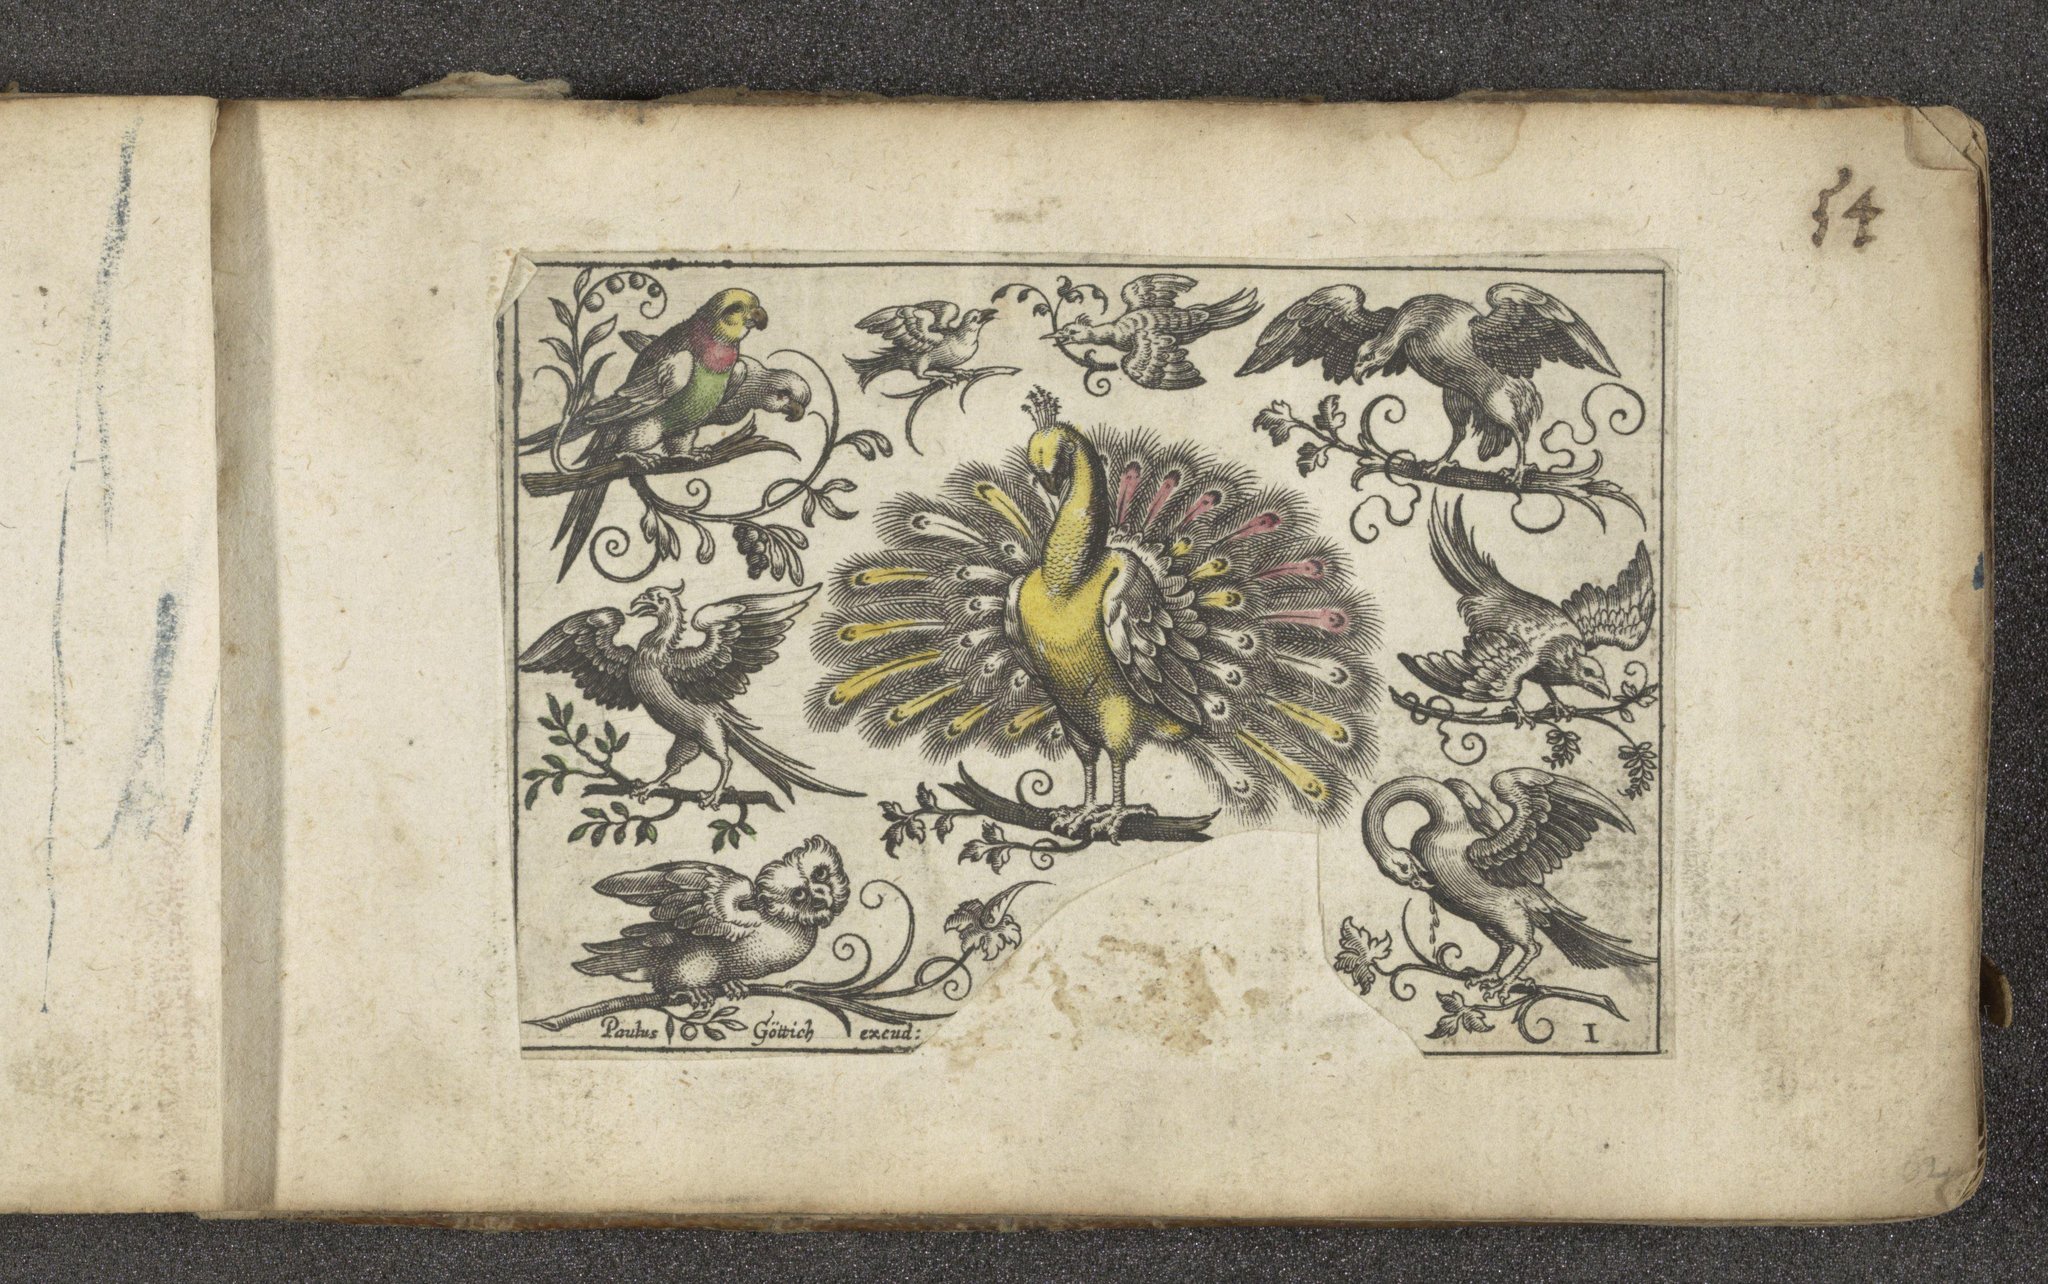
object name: ornament print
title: Vogels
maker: paul göttich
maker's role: graveur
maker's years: 1586-1622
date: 1596-1622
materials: paper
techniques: colour, engraving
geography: augsburg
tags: water-birds: swan, birds, ornamental birds: parrot, ornamental birds: peacock, predatory birds, owls, ornamental birds: parakeet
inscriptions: inscription: ‘54’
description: Een pauw in volle glorie, omringd door minstens negen andere vogels waaronder twee papagaaien of parkieten, een roofvogel, een uil en een zwaan. De prent maakt deel uit van een album.